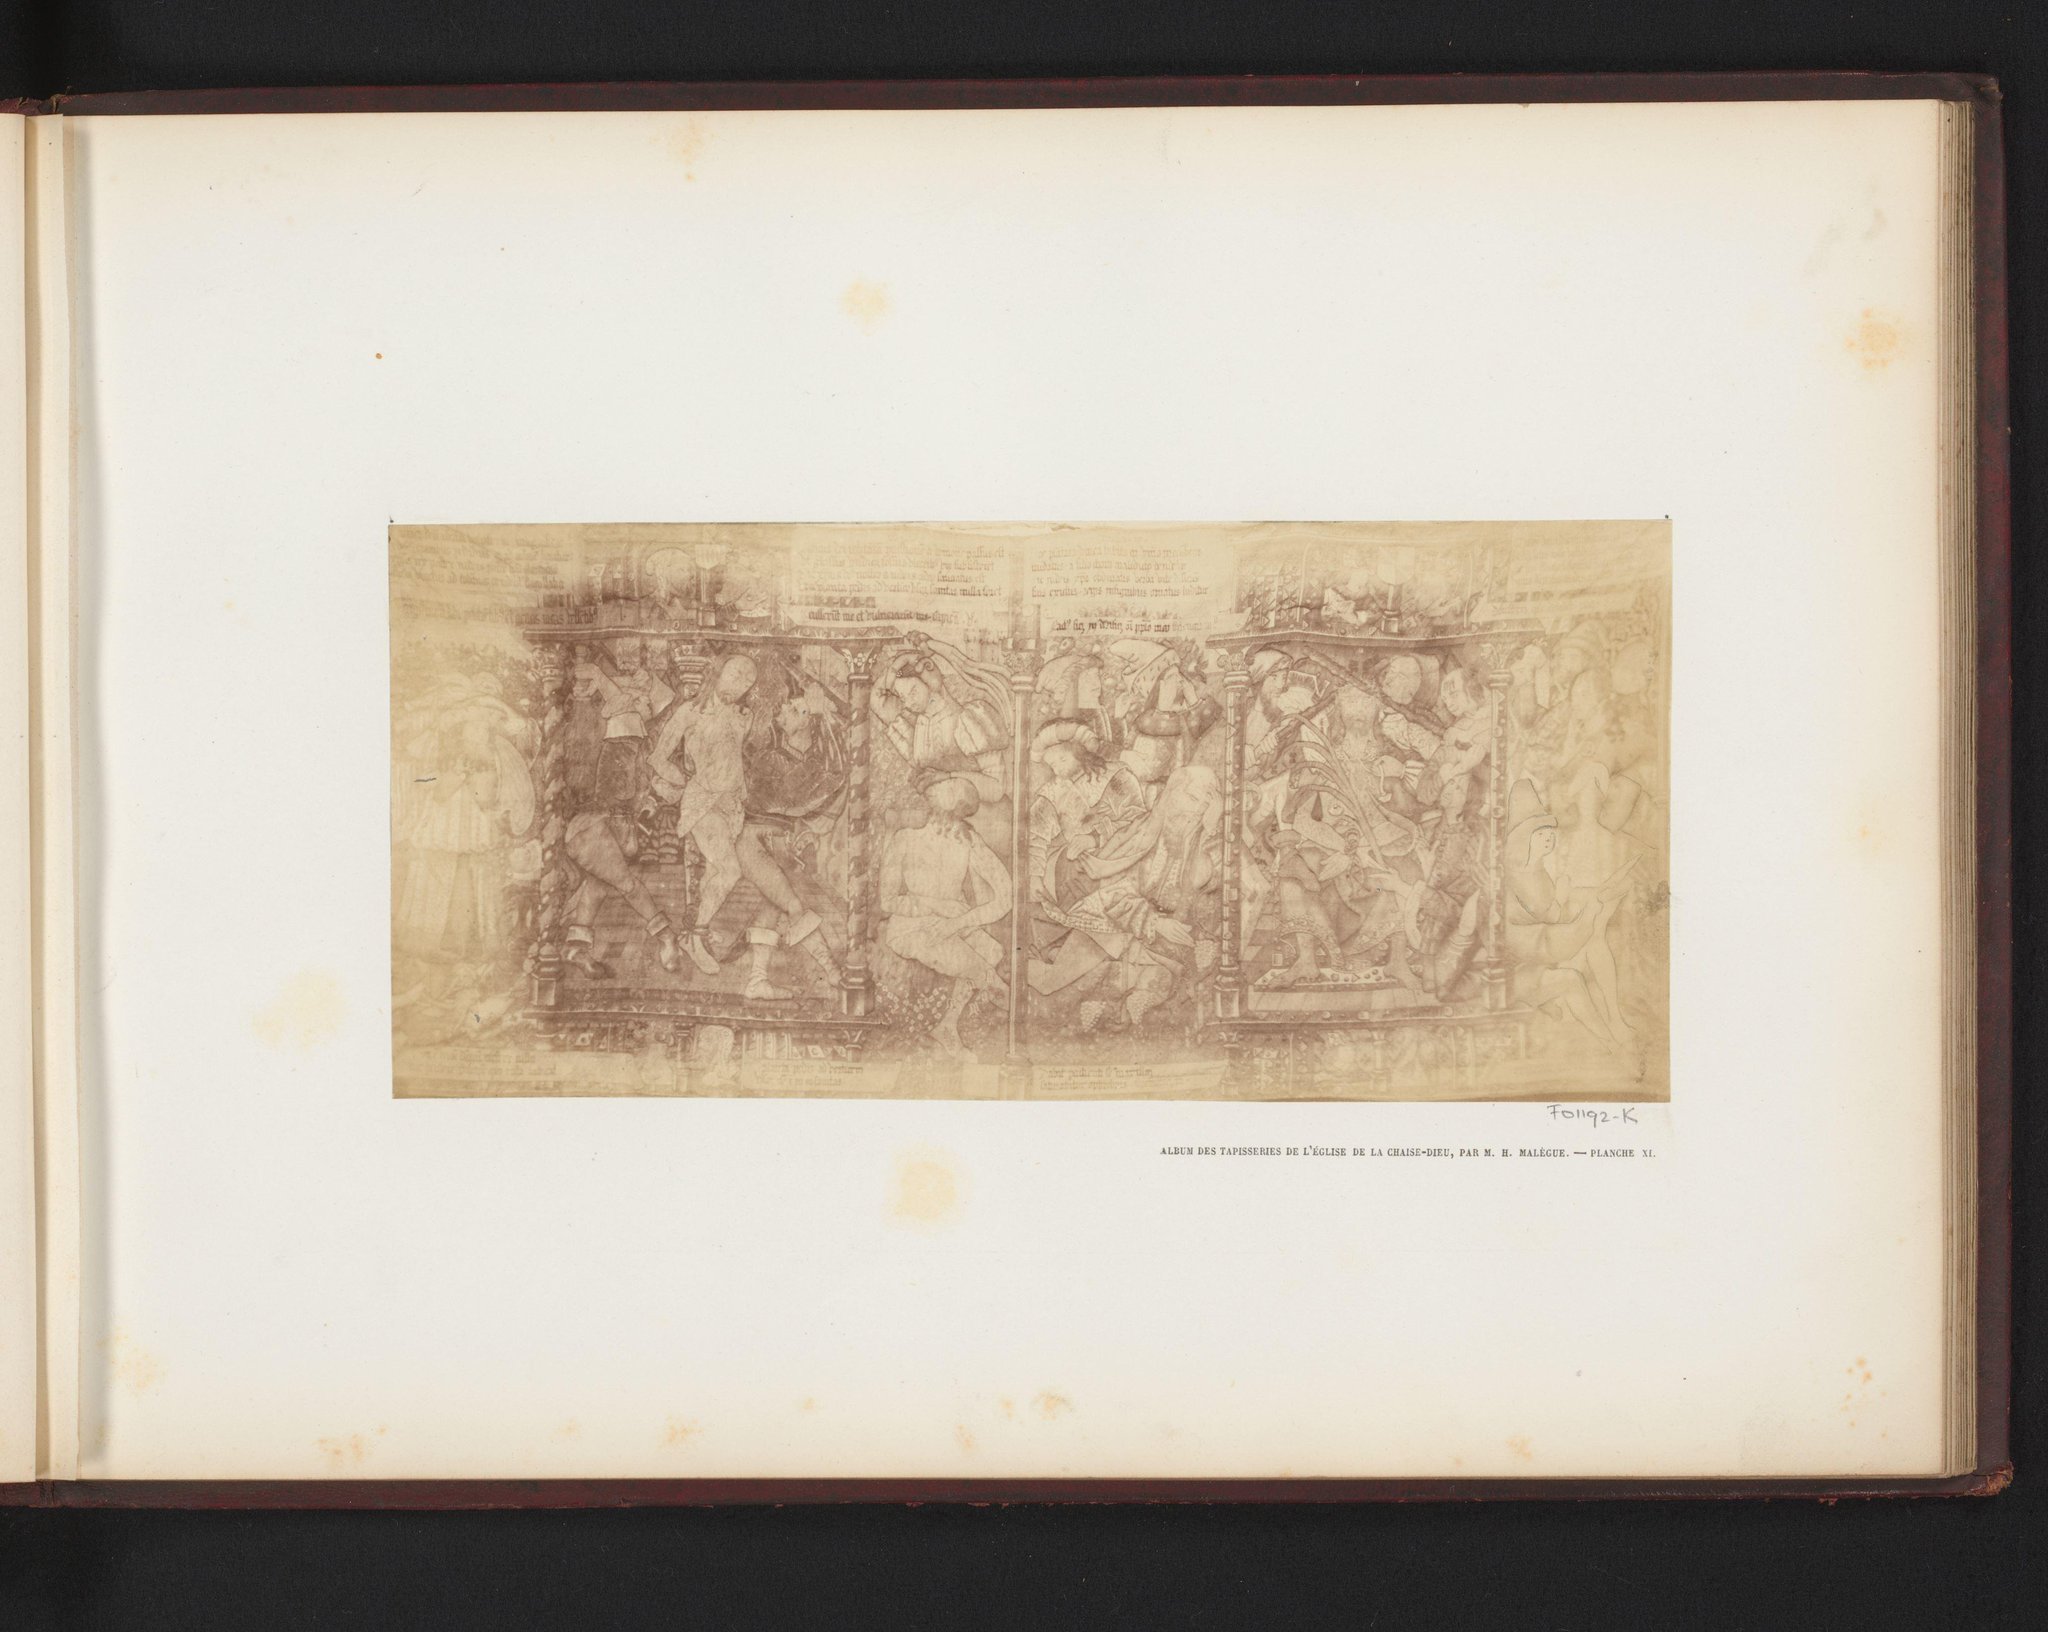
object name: photograph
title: Tapijt met de geseling en doornenkroning van Christus en prefiguraties in een kerk te La Chaise-Dieu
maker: hippolyte malègue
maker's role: archeoloog, fotograaf, schrijver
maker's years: 1825-1901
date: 1868-1873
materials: photographic support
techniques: albumen print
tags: tapestry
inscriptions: inscription: ‘album des tapisseries de l'église de la Chaise-Dieu, par M. H. Malegue - Planche XI’